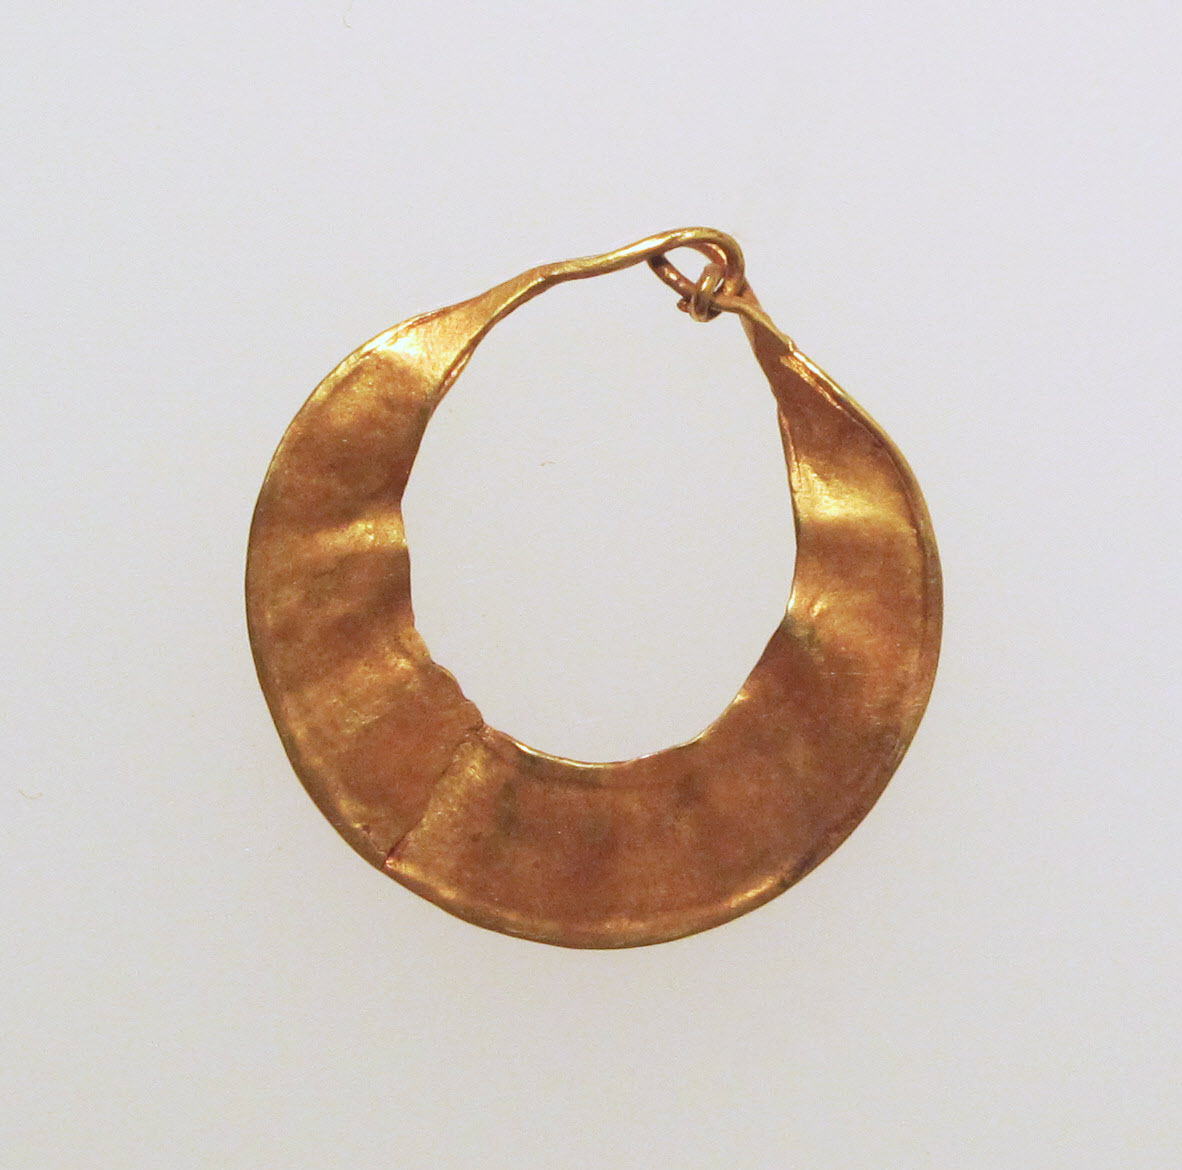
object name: earring, crescent shaped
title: Earring, crescent-shaped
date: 7000 BCE-330 CE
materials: gold